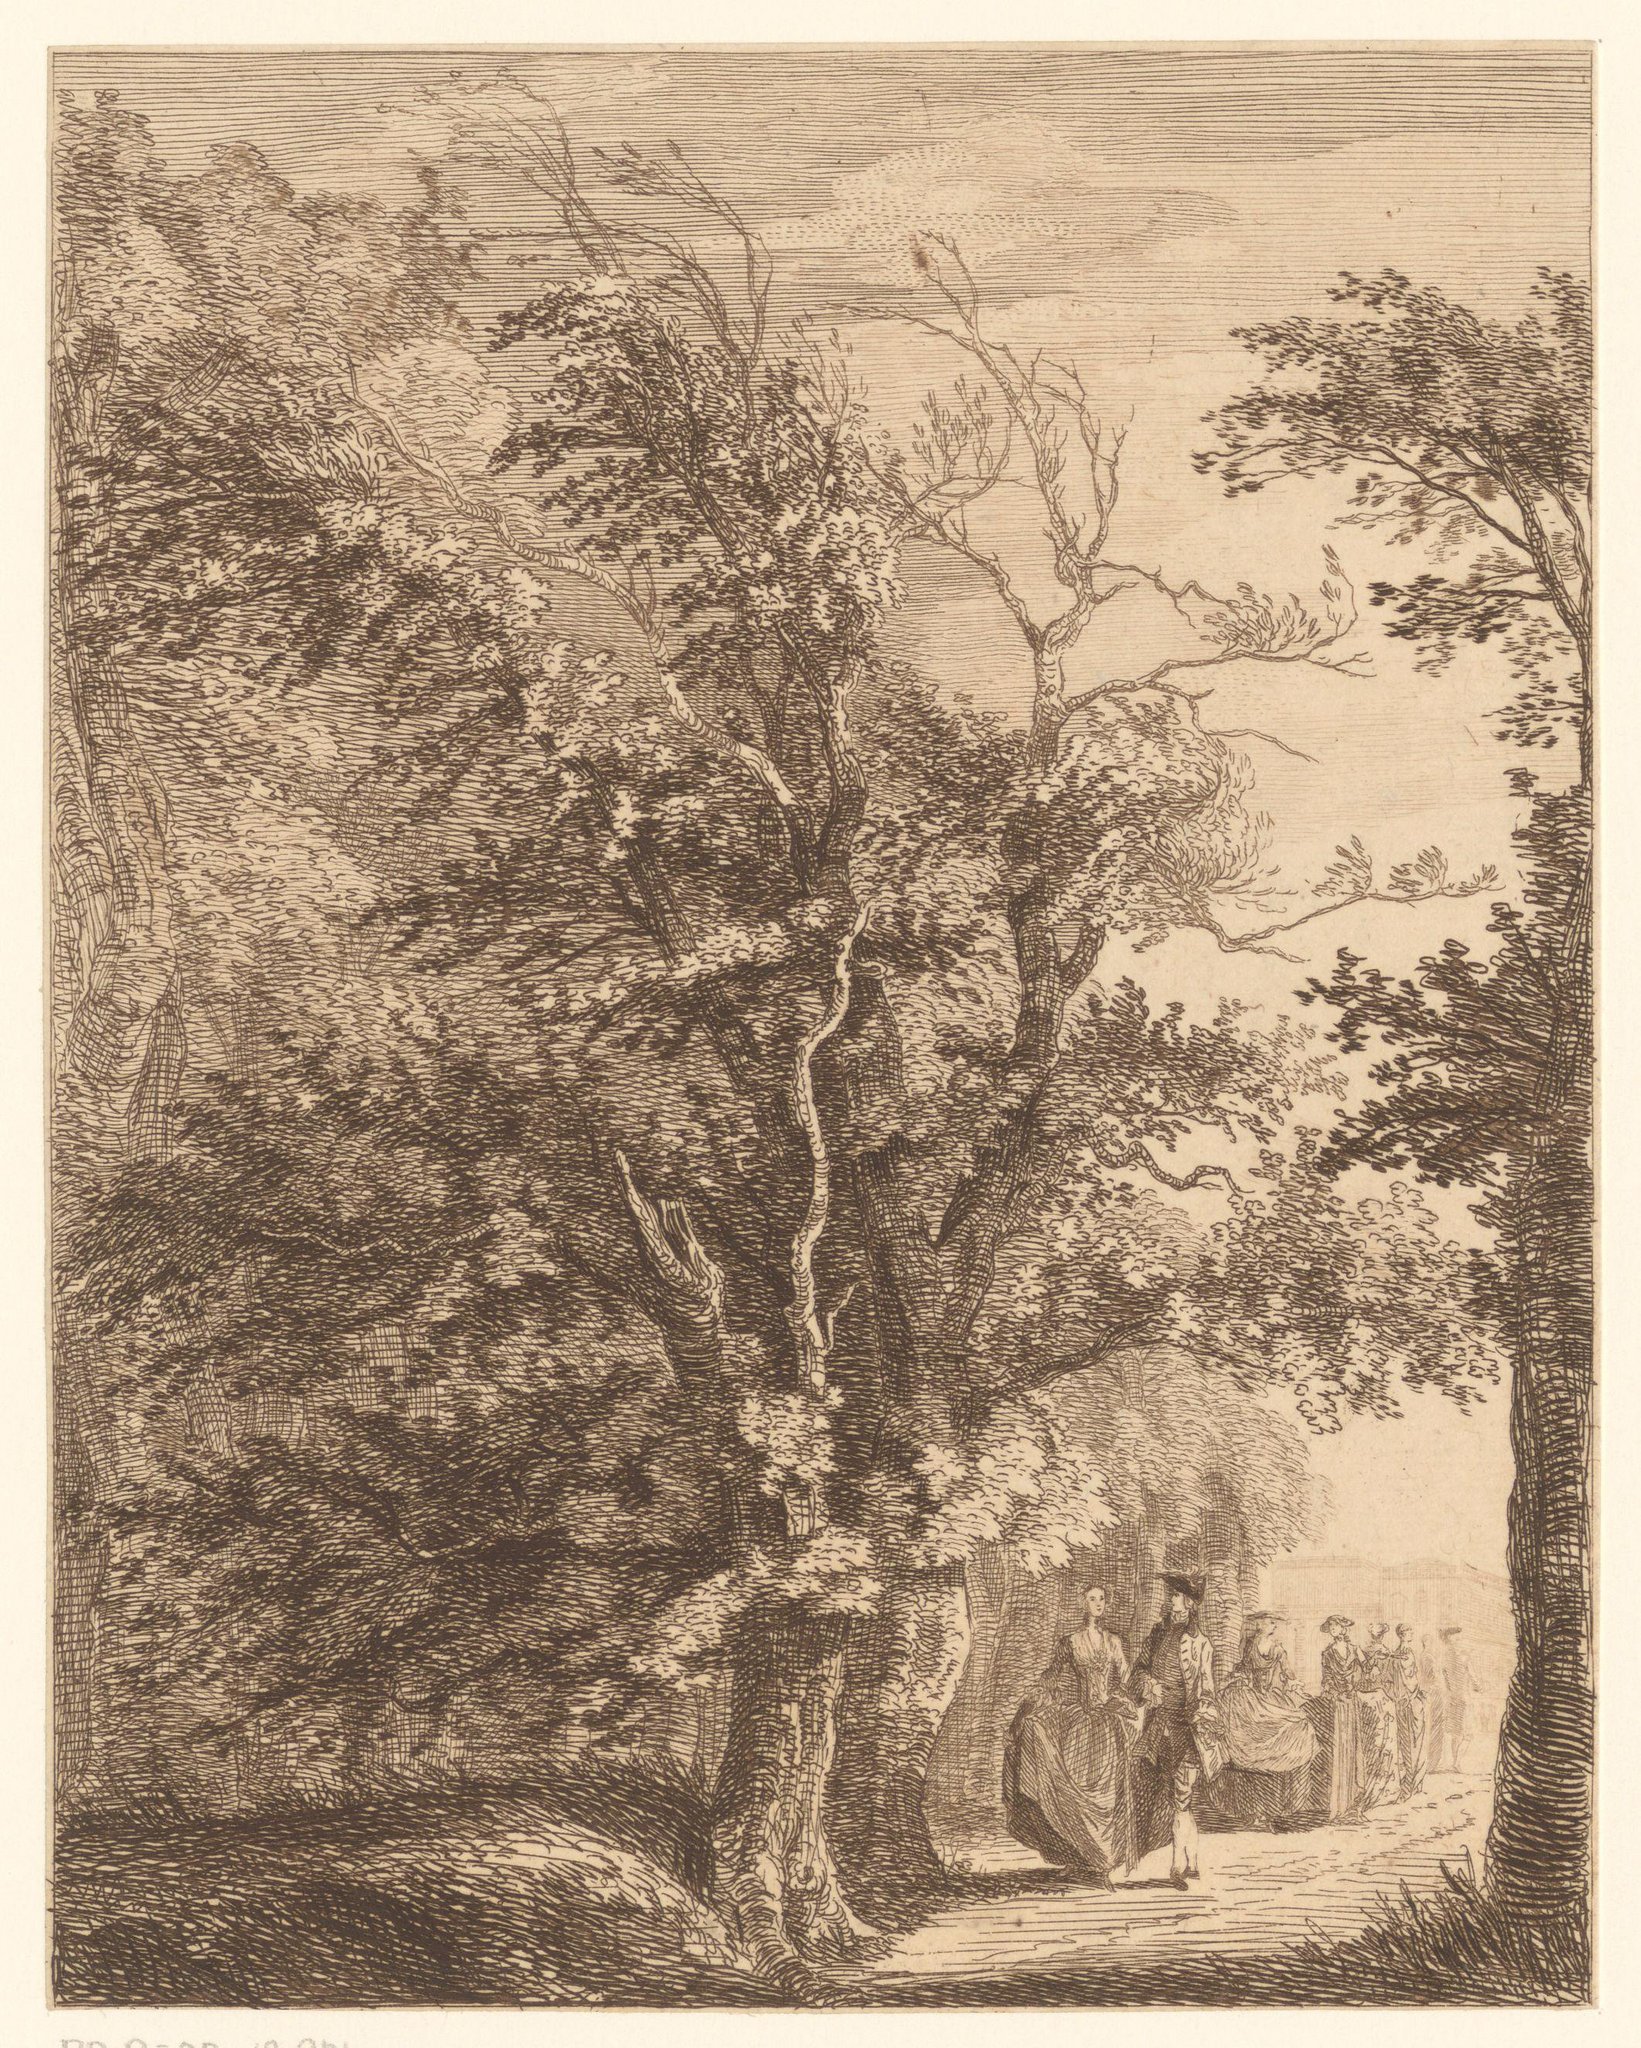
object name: print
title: Stoet dames en heren op een bospad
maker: paul sandby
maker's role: draughtsman, print maker, publisher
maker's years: 1725-1809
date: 1750-1751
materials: paper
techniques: etching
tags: forest path or lane (+ landscape with figures, staffage)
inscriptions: collector's mark: Lugt 2228